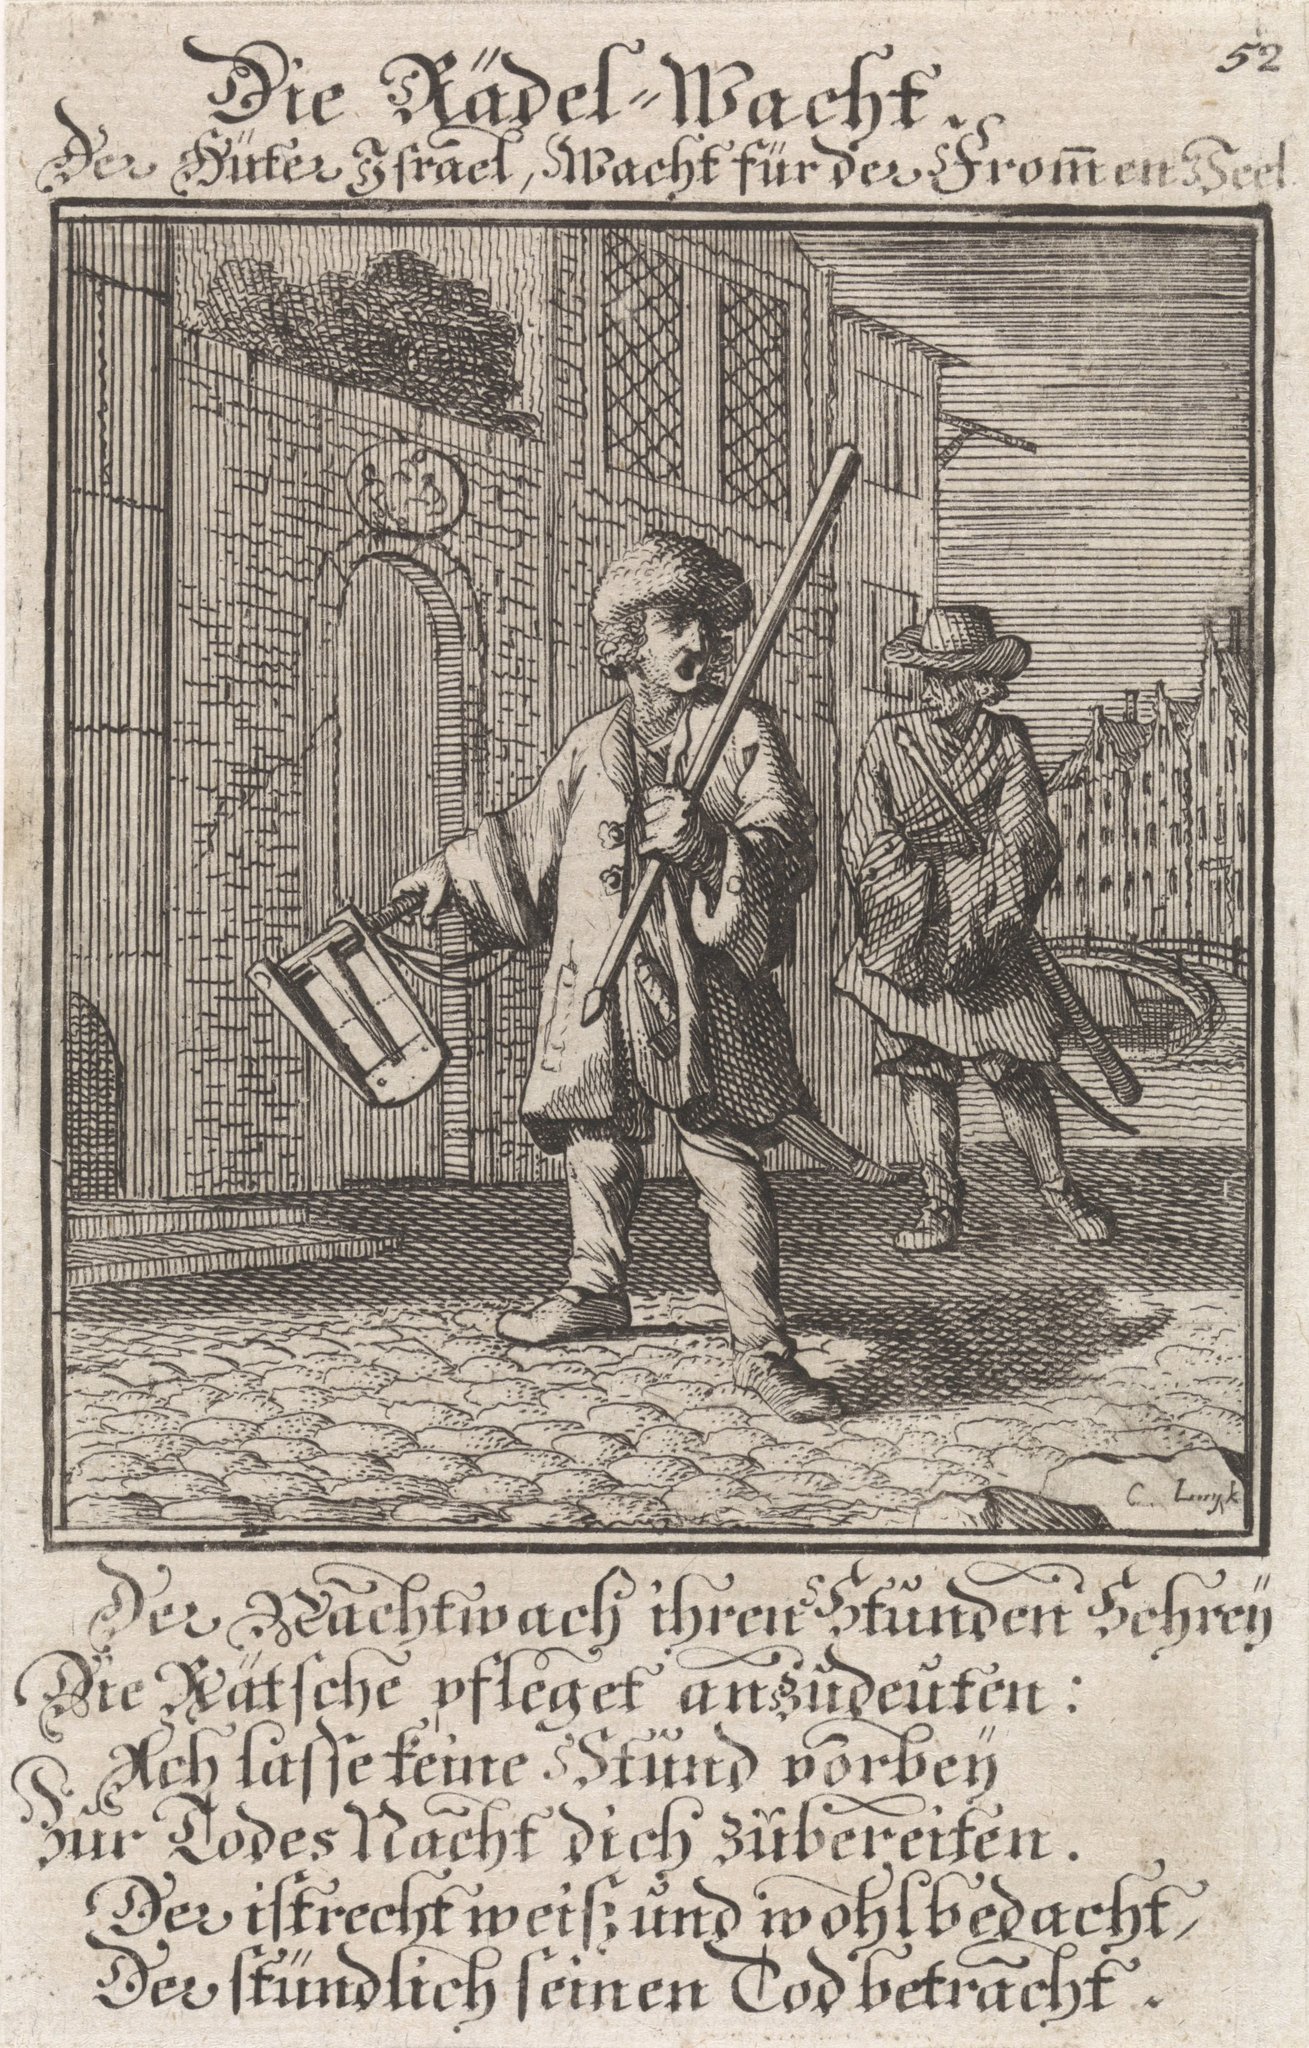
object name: print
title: Die Radel Wacht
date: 1711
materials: paper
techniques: etching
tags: night patrol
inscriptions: collector's mark: Lugt 2228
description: Illustratie uit: Sancta Clara, Abraham à. Etwas für Alle, das ist: Eine kurtze Beschreibung allerley Stands- Ambts- und Gewerbs-Persohnen (...), 3 delen (1699-1733). Würtzburg: Martin Frank Hertz, 1711, dl. II, p. 511. Het betreft hier de tweede druk van deel II.